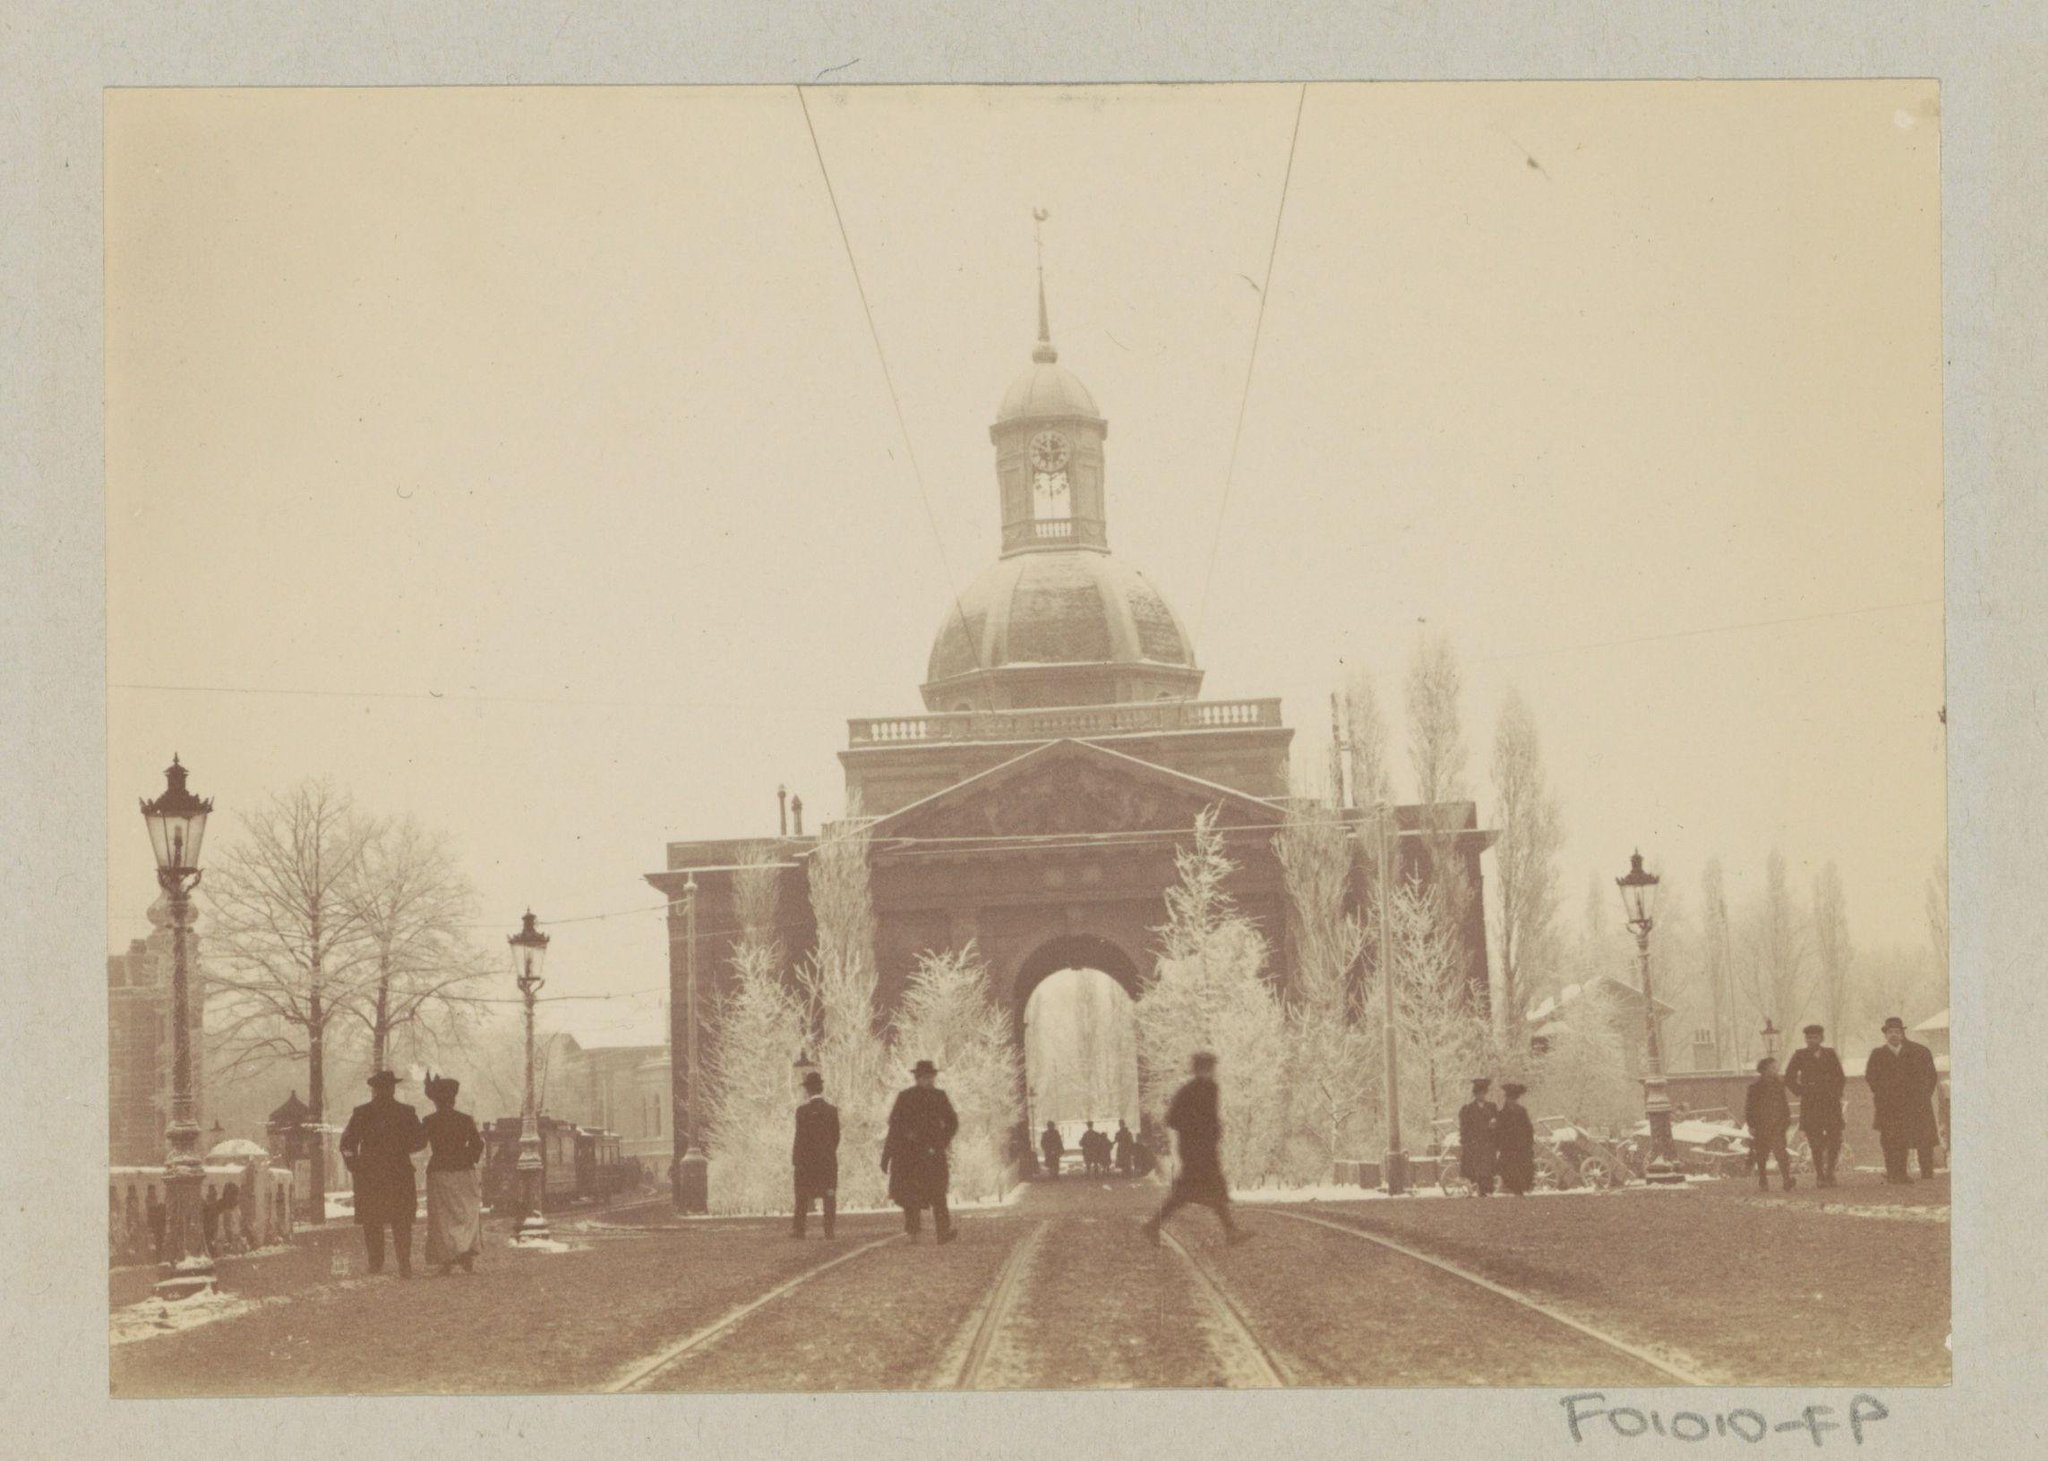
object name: photograph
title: Besneeuwde Muiderpoort te Amsterdam, gezien vanuit het oosten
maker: Anonymous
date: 1900-1910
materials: photographic support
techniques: daylight paper print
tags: winter landscape; landscape symbolizing winter (the four seasons of the year), snow, city-gate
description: Onderdeel van Familiealbum met onder meer foto's van Wijnhandel Kraaij & Co. Bordeaux-Amsterdam.